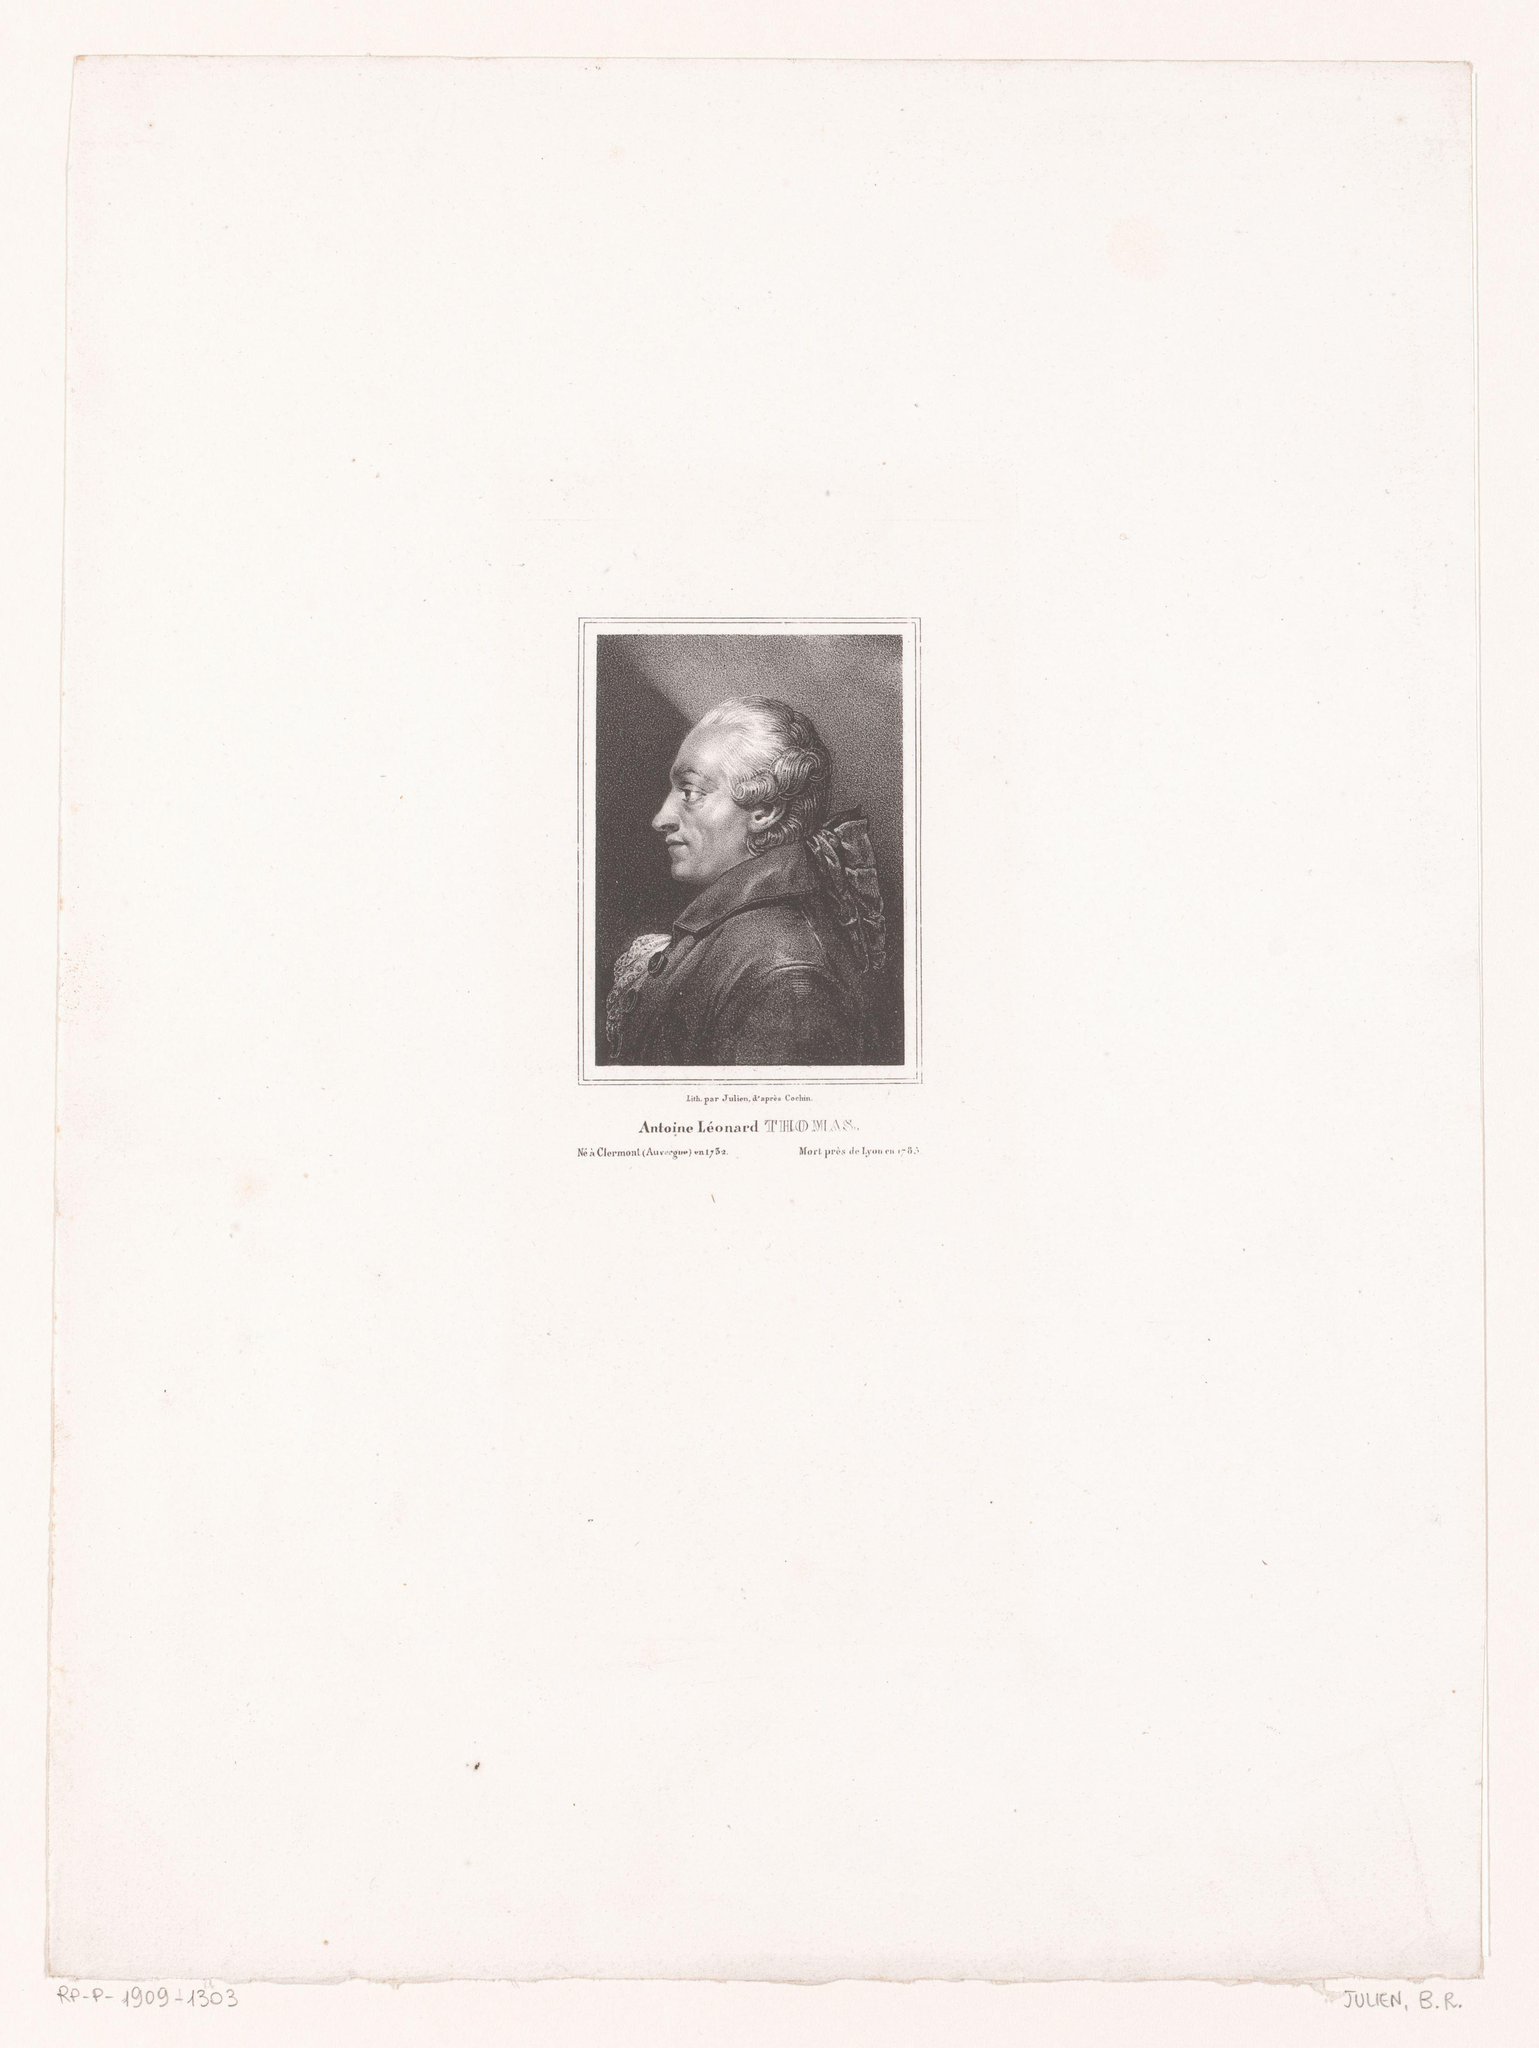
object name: print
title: Portret van Antoine Léonard Thomas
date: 1830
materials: paper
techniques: lithograph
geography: paris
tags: historical persons, portrait of a writer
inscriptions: collector's mark: Lugt 2228a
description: Prent gebruikt voor: Illustrations du Cours de Littérature de la Harpe, ou collection de 400 portraits destinés à l'ornement de cet ouvrage. Parijs: Boblet, 1830.